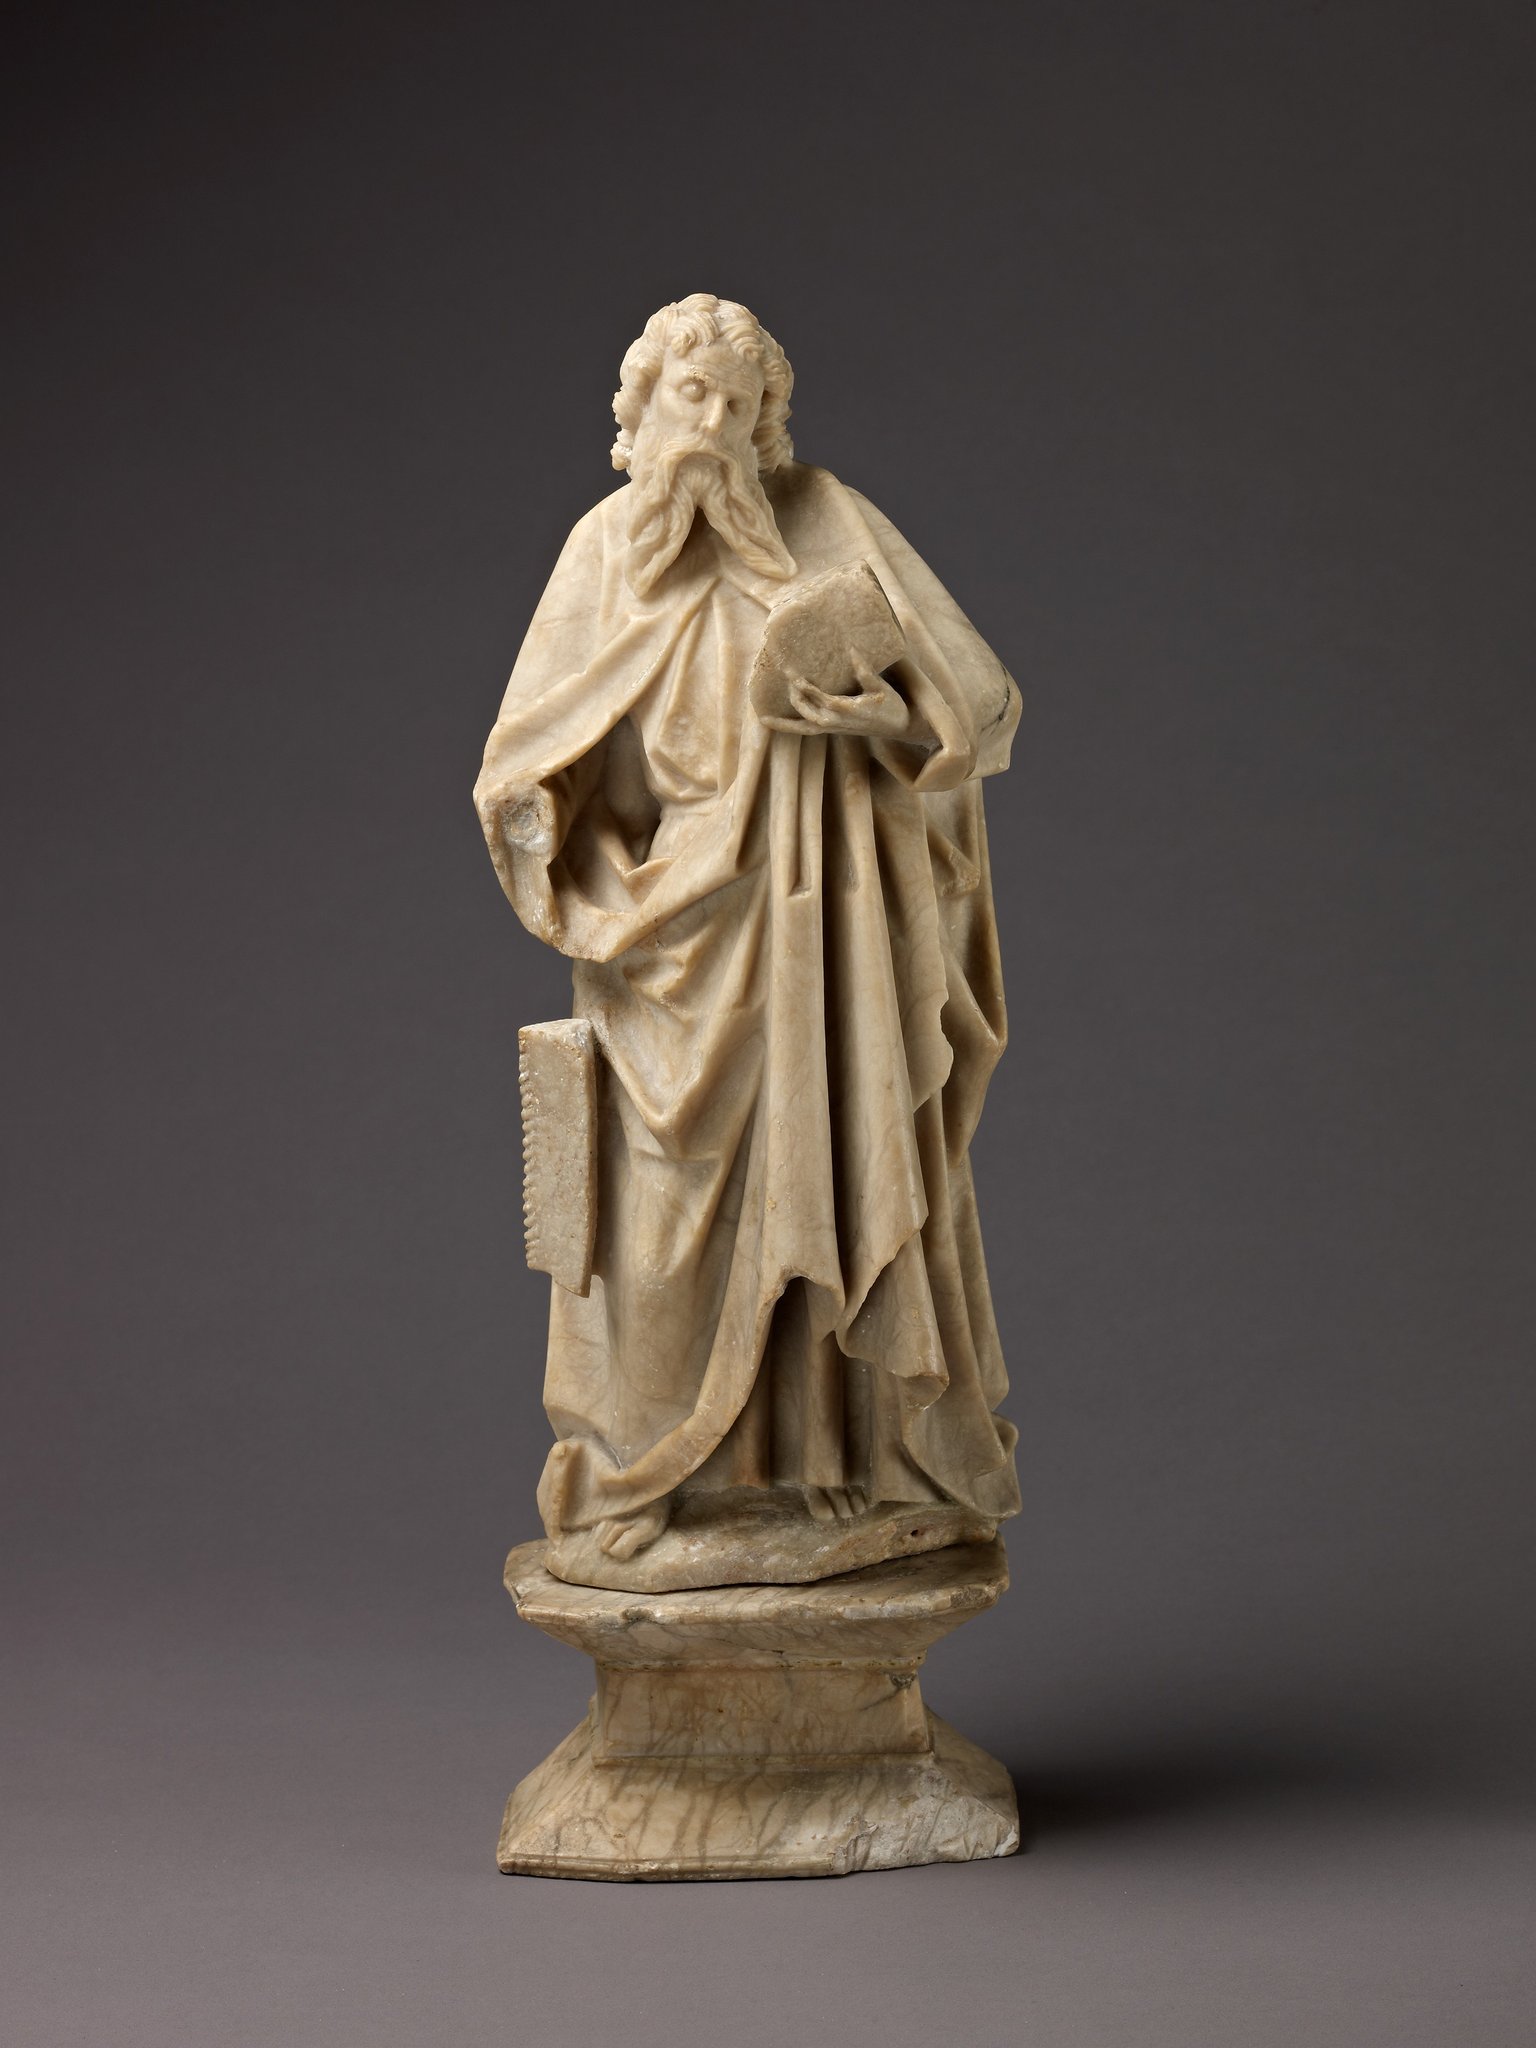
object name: statue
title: Saint Simon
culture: dutch or french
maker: southern netherlands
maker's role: artist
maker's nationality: southern netherlands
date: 1450-1470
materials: alabaster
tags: men,saints